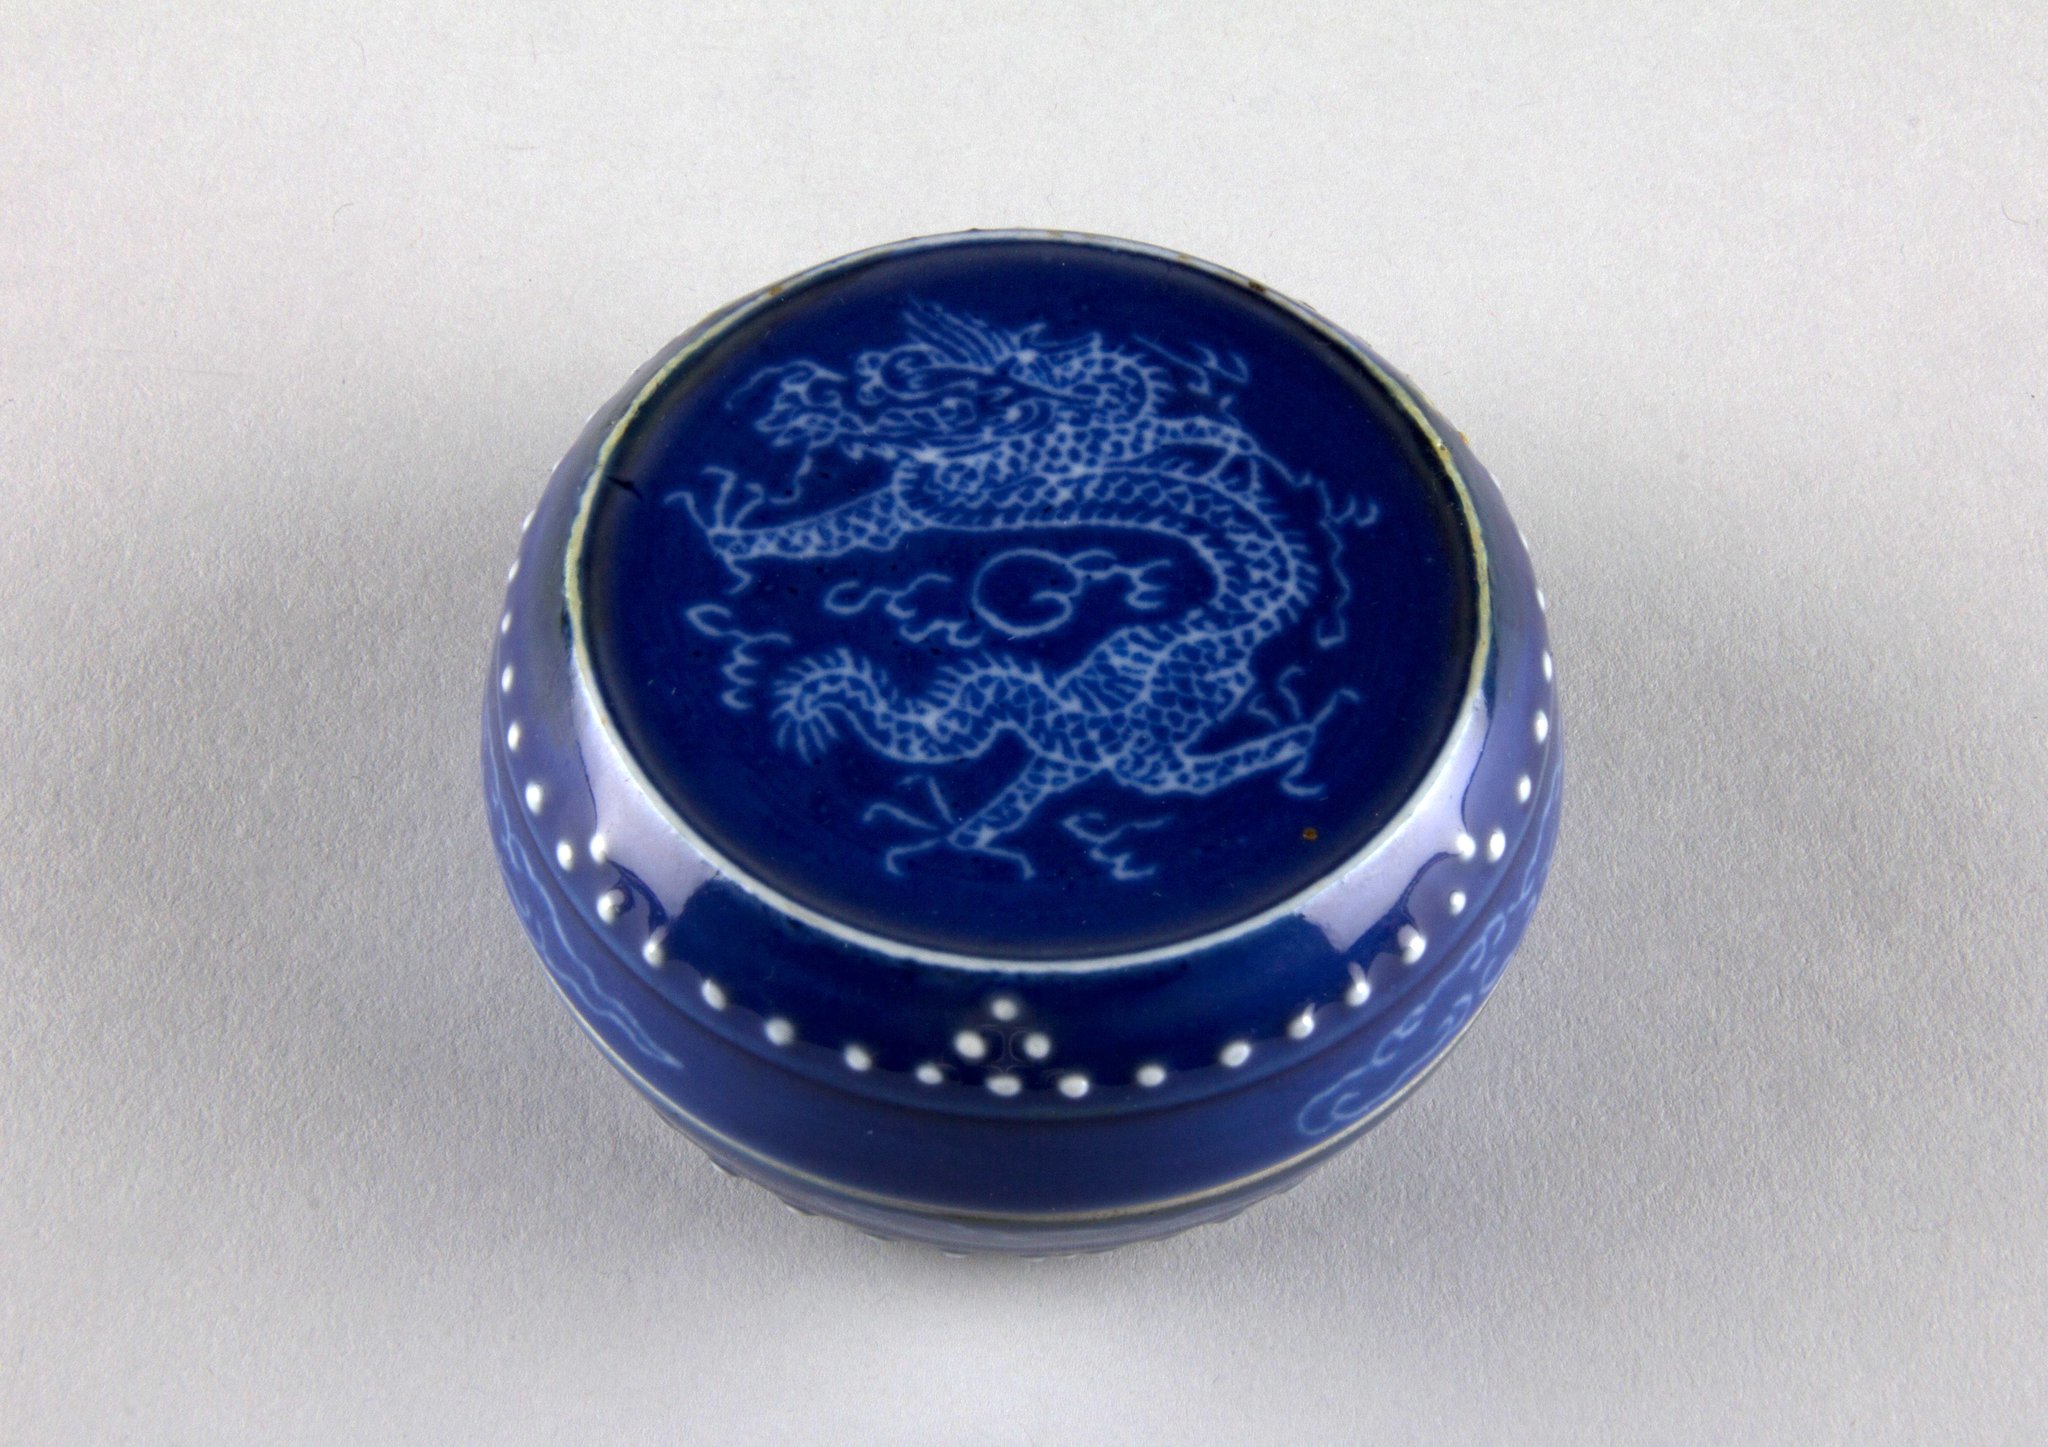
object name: seal paste box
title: Seal paste box with dragon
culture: chinese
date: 1701-1800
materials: glaze, porcelain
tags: dragons